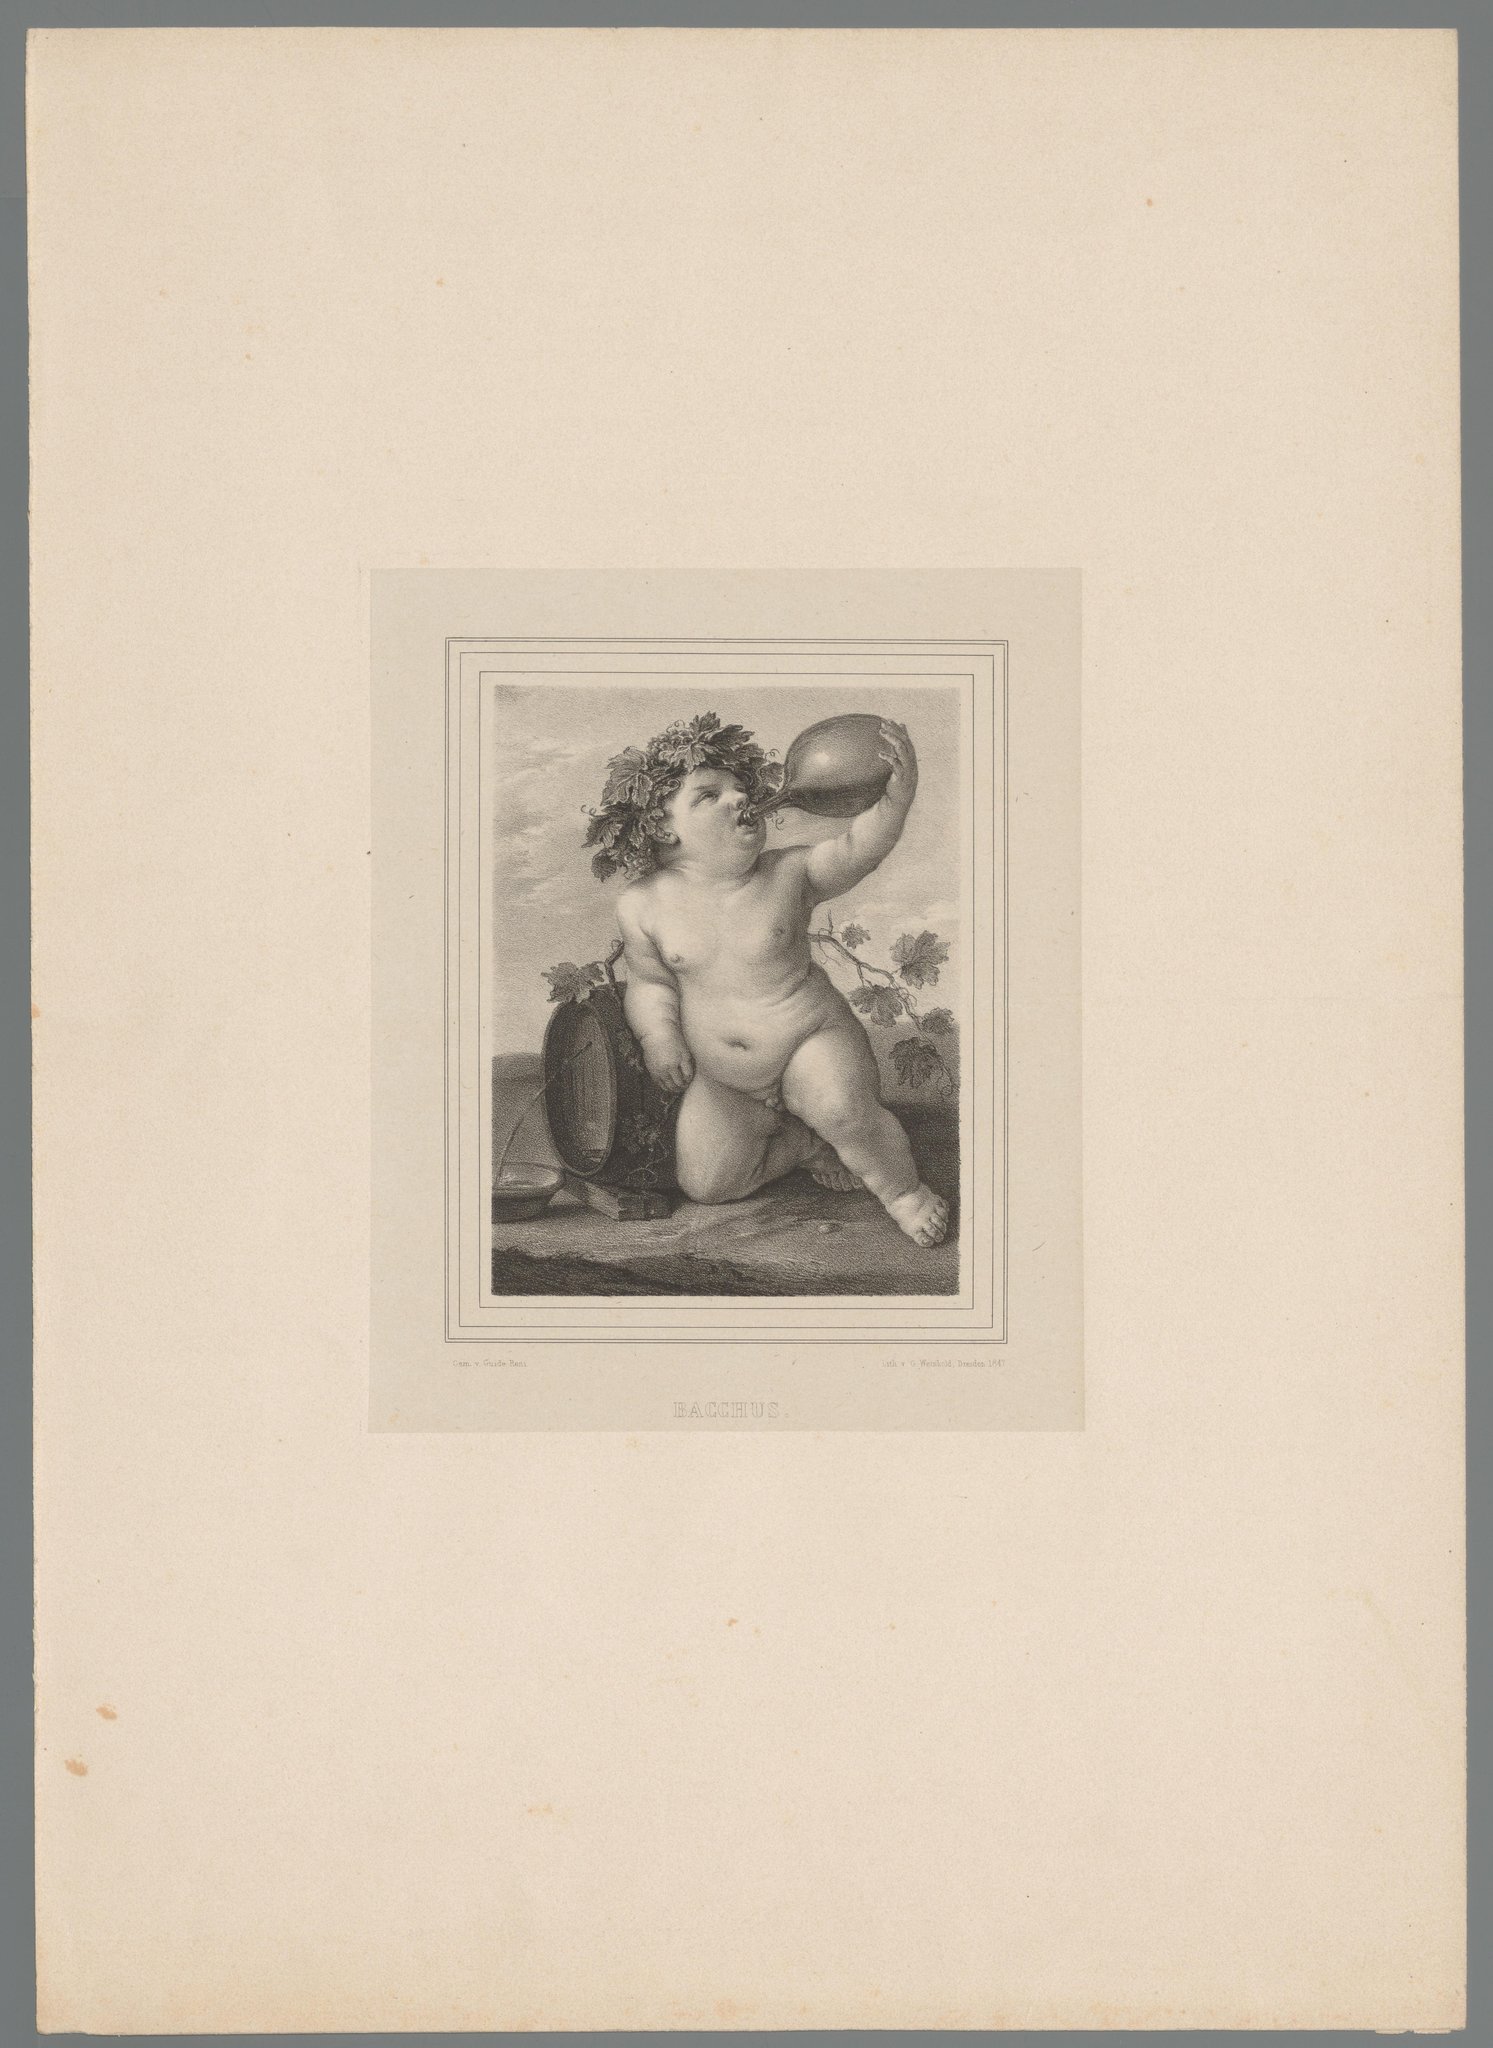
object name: print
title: Bacchus drinkt wijn uit een fles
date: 1847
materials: paper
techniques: lithograph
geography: dresden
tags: (story of) bacchus (dionysus), liber, wine ~ alcoholic drinks, drinking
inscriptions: collector's mark: Lugt 2228